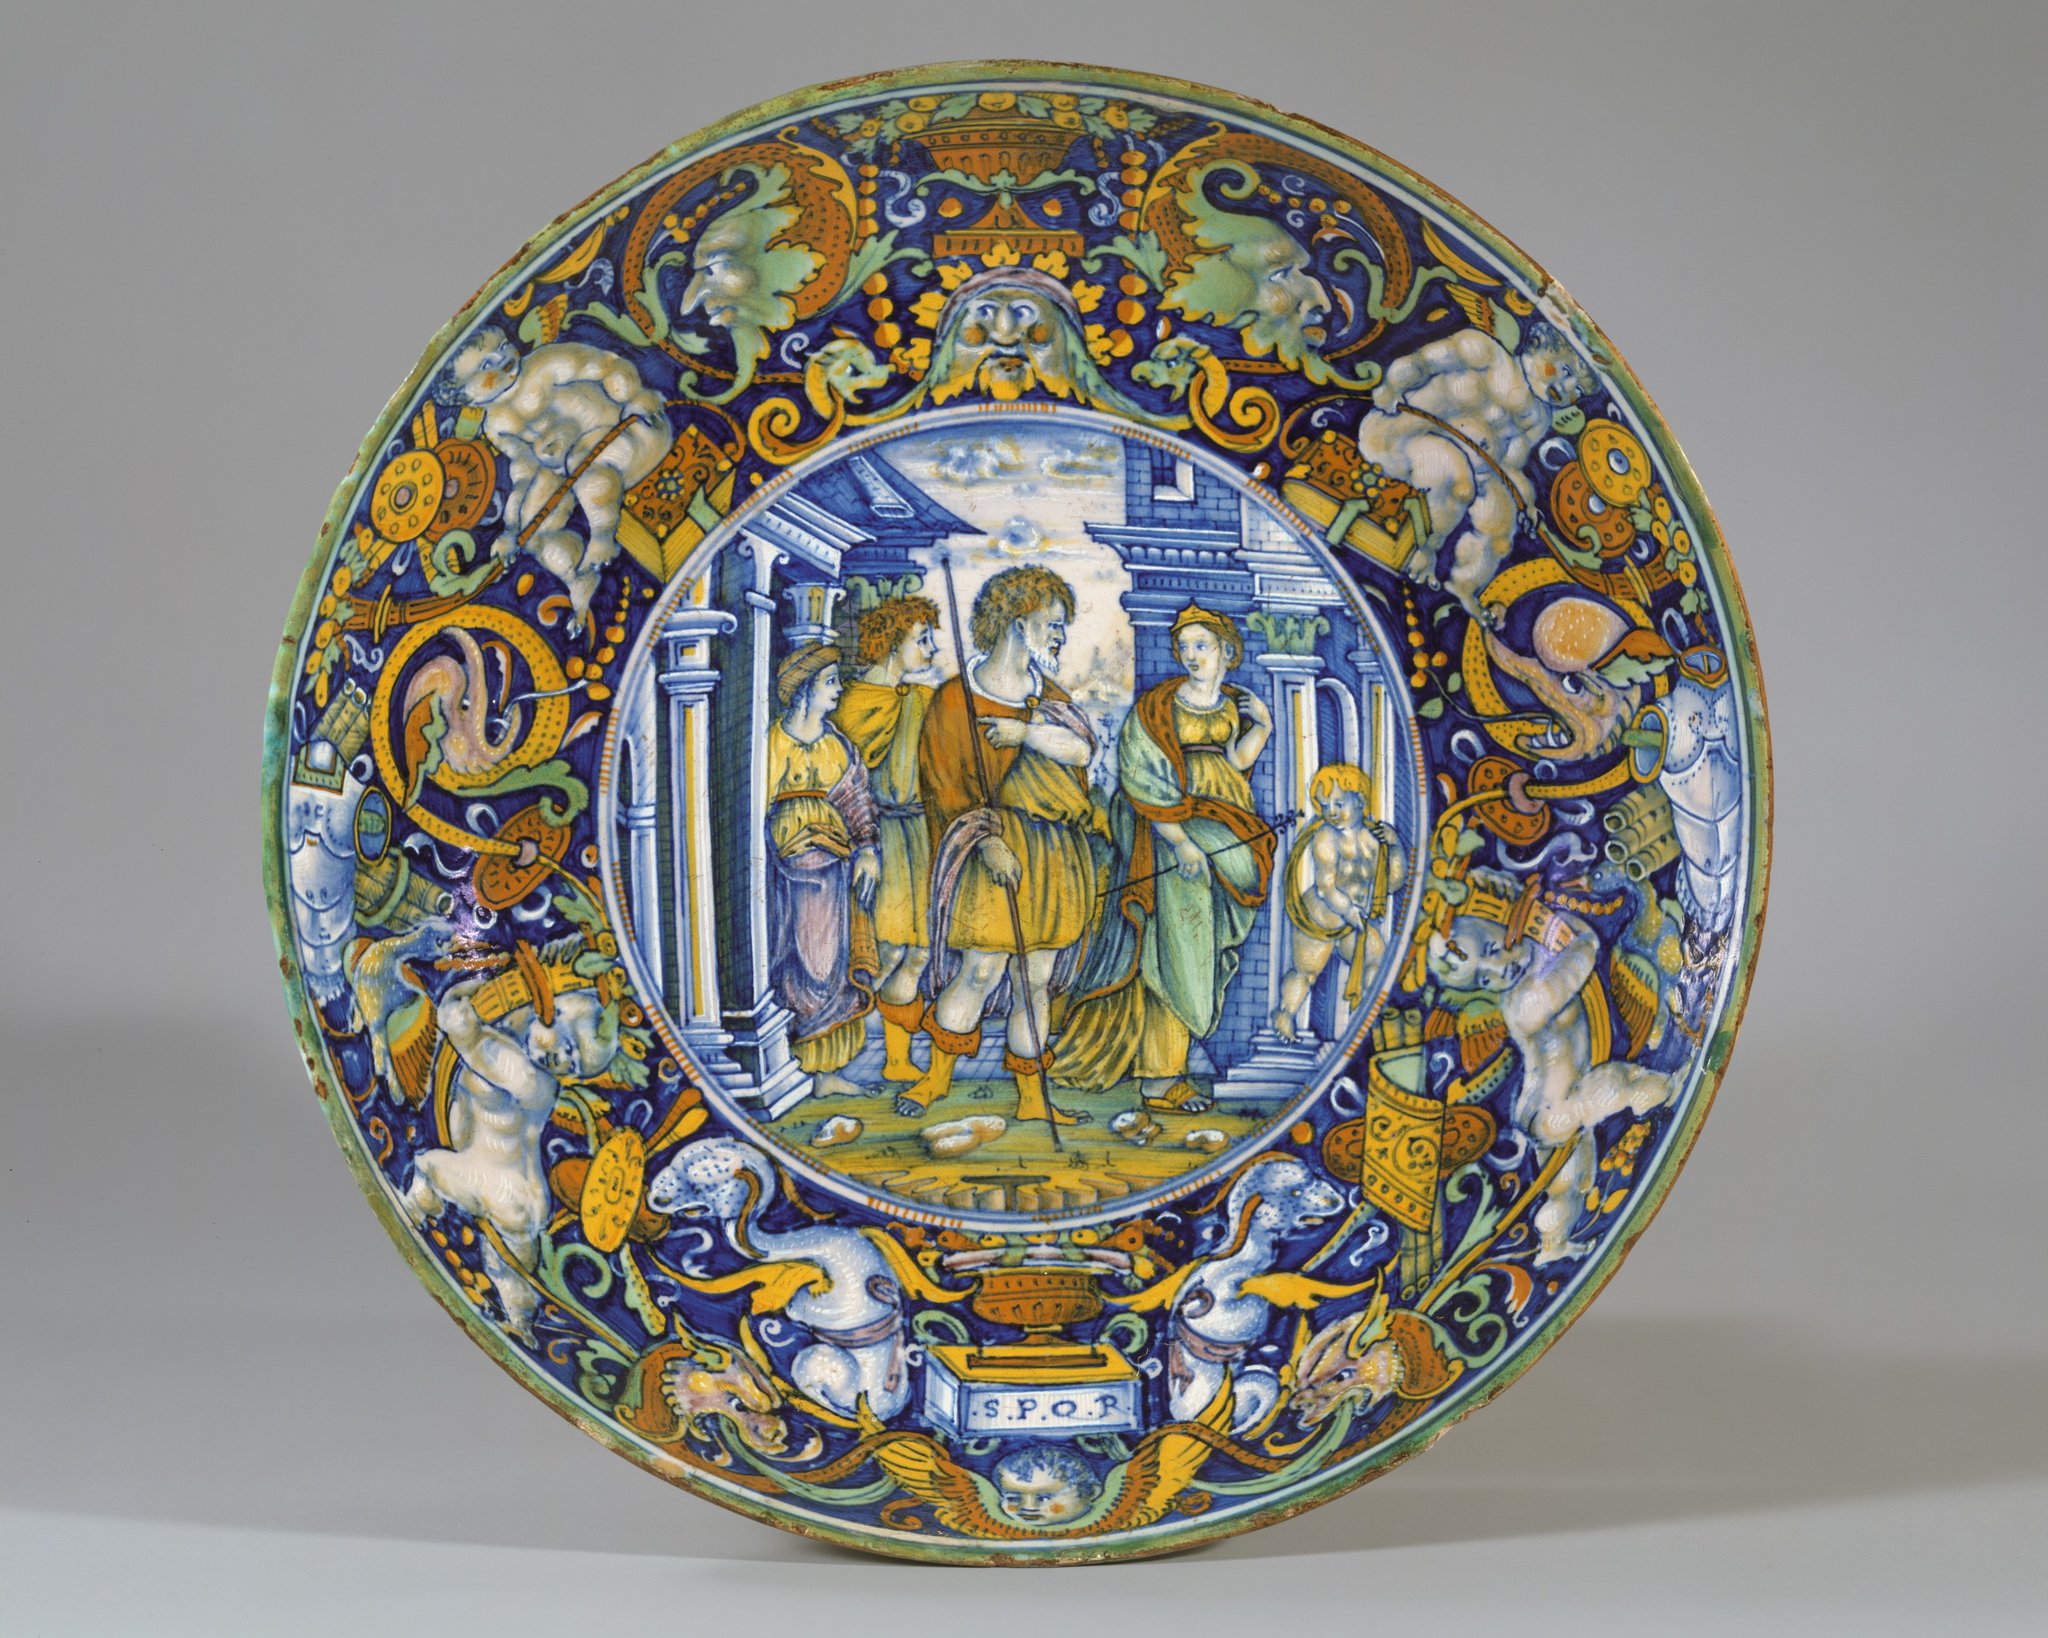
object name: dish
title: Dish (coppa): The story of Aeneas: Queen Dido of Carthage welcomes Aeneas and his son.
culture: italian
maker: workshop of giovanni maria vasaro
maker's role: artist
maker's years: 1500-1530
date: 1520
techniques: maiolica, glazing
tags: queens,women,aeneas